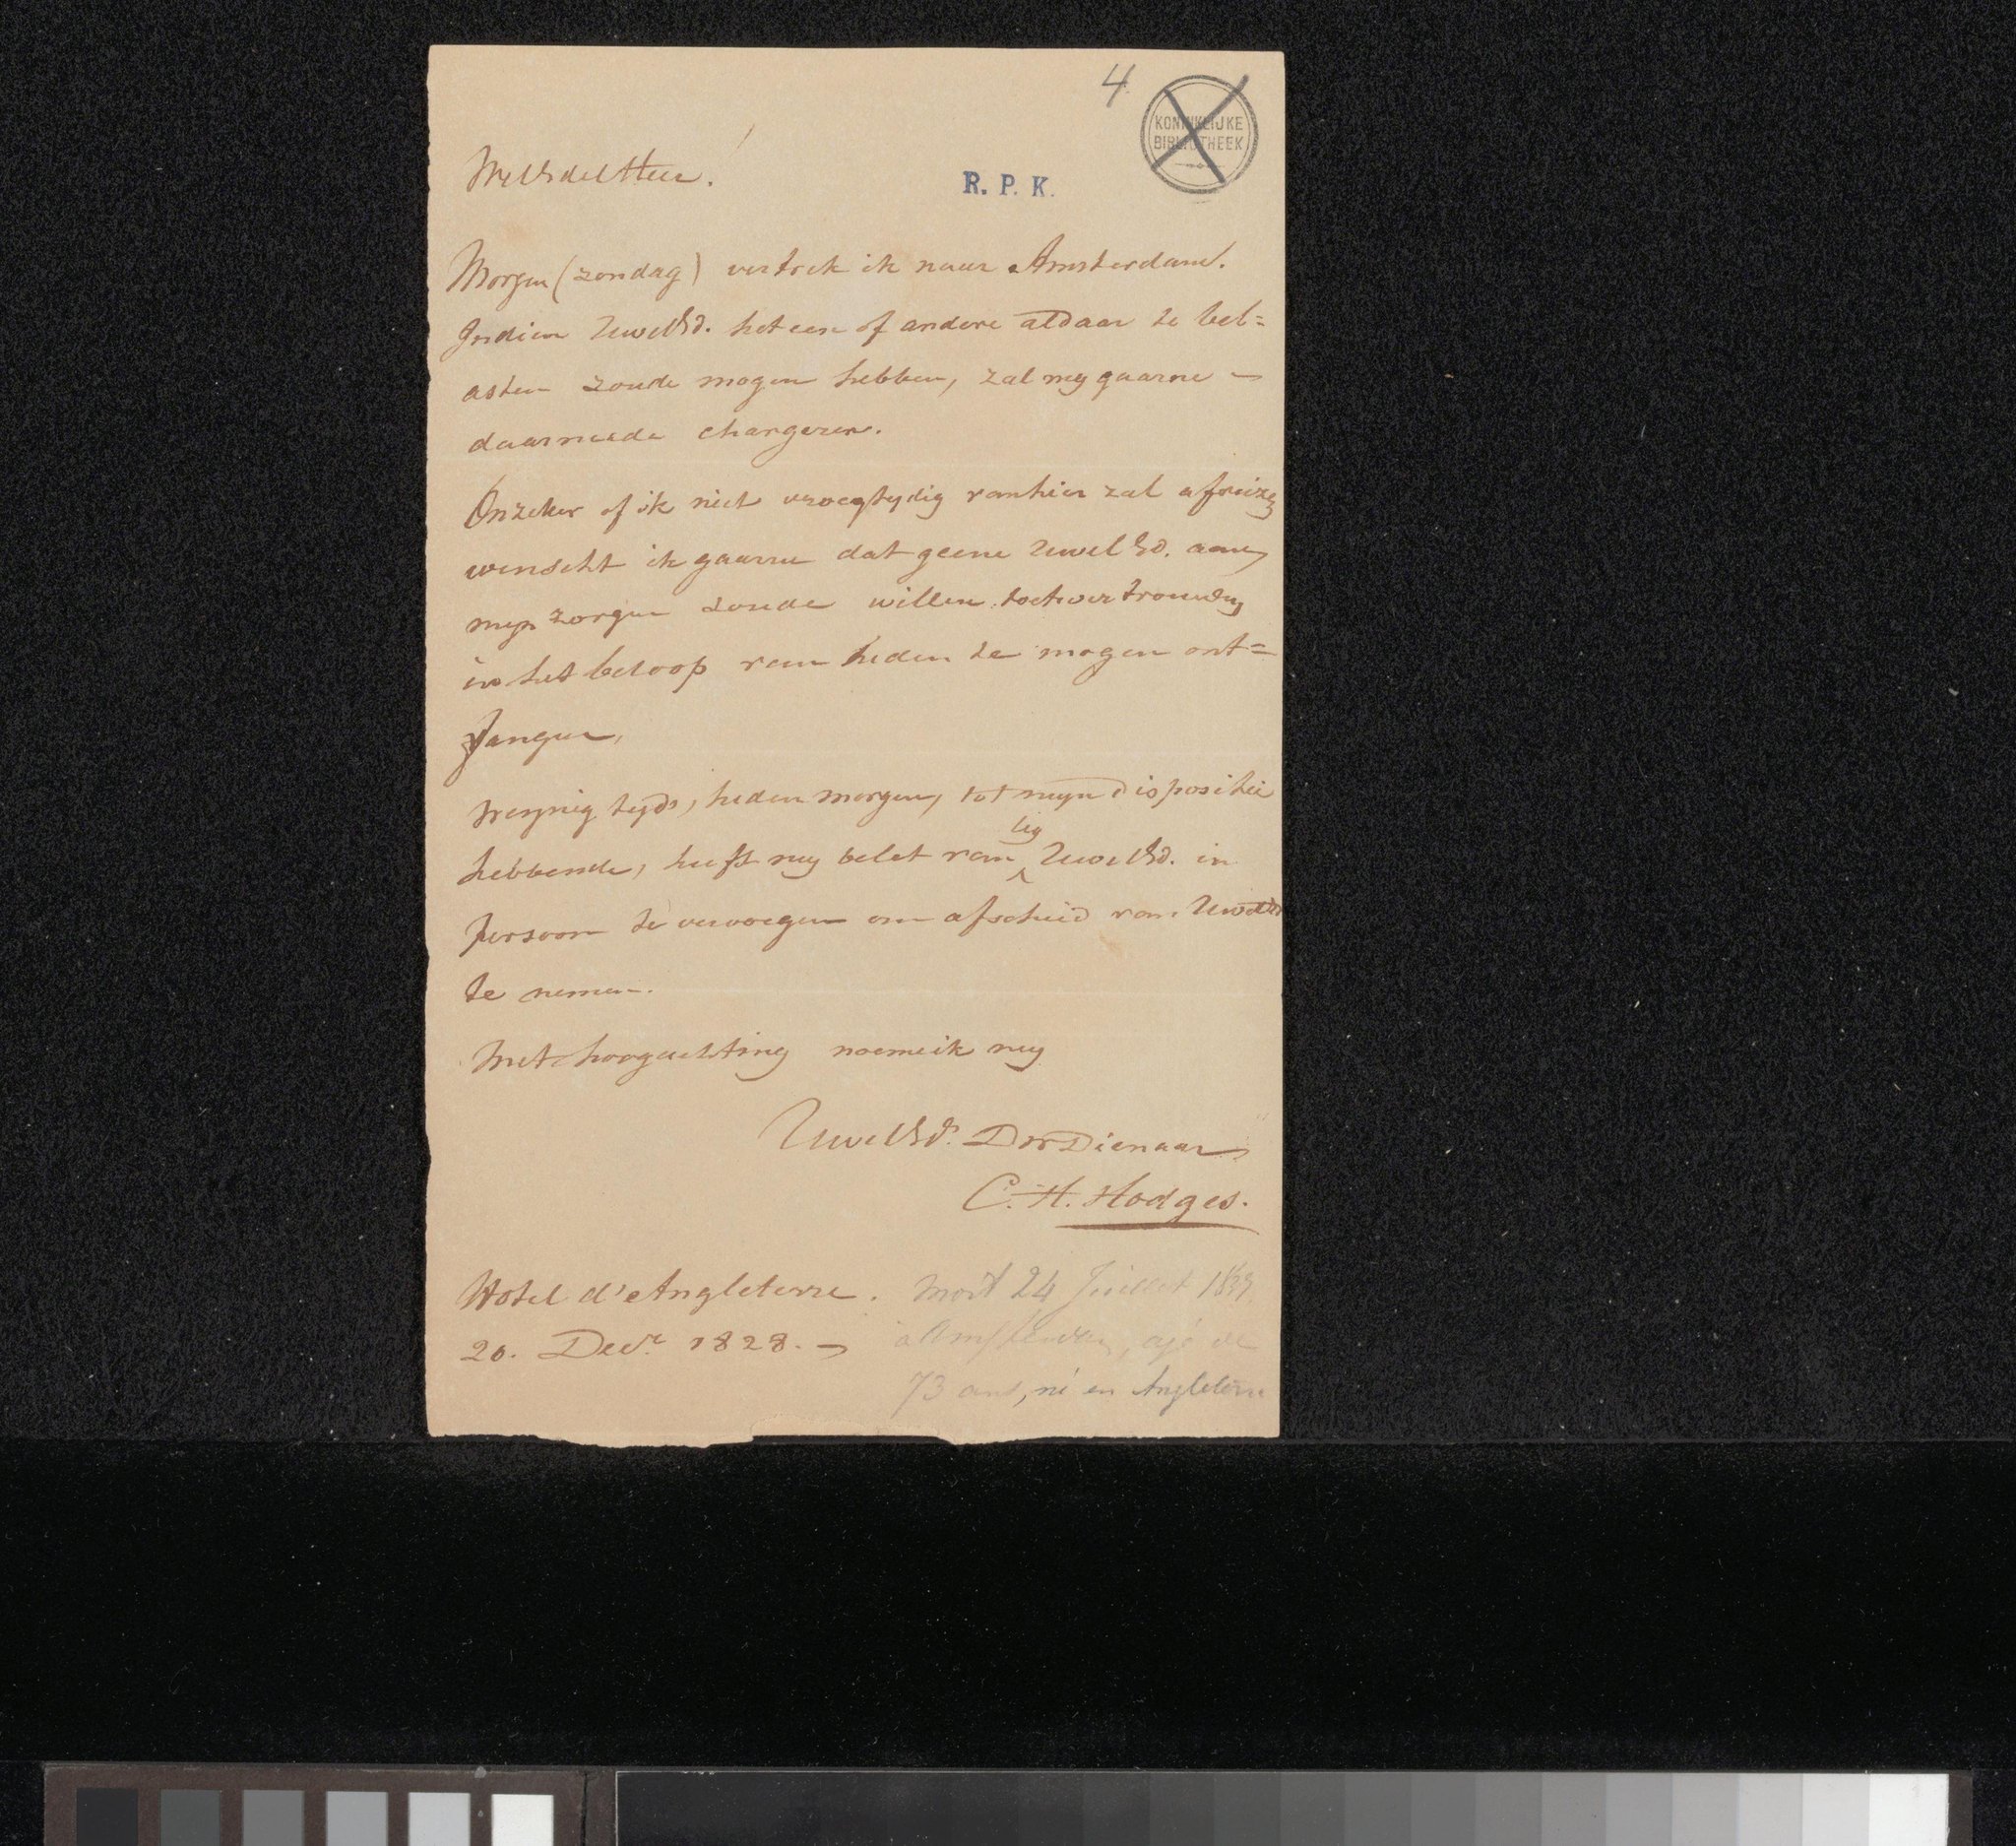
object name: letter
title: Brief aan anoniem, mogelijk aan Ernst Willem Jan Bagelaar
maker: charles howard hodges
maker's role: draughtsman, painter, print maker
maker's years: 1764-1837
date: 1828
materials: ink, paper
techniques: pen, writing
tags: draughtsman, ernst willem jan bagelaar, amsterdam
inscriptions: collector's mark: ‘KONINKLIJKE BIBLIOTHEEK’, collector's mark: Lugt 2233